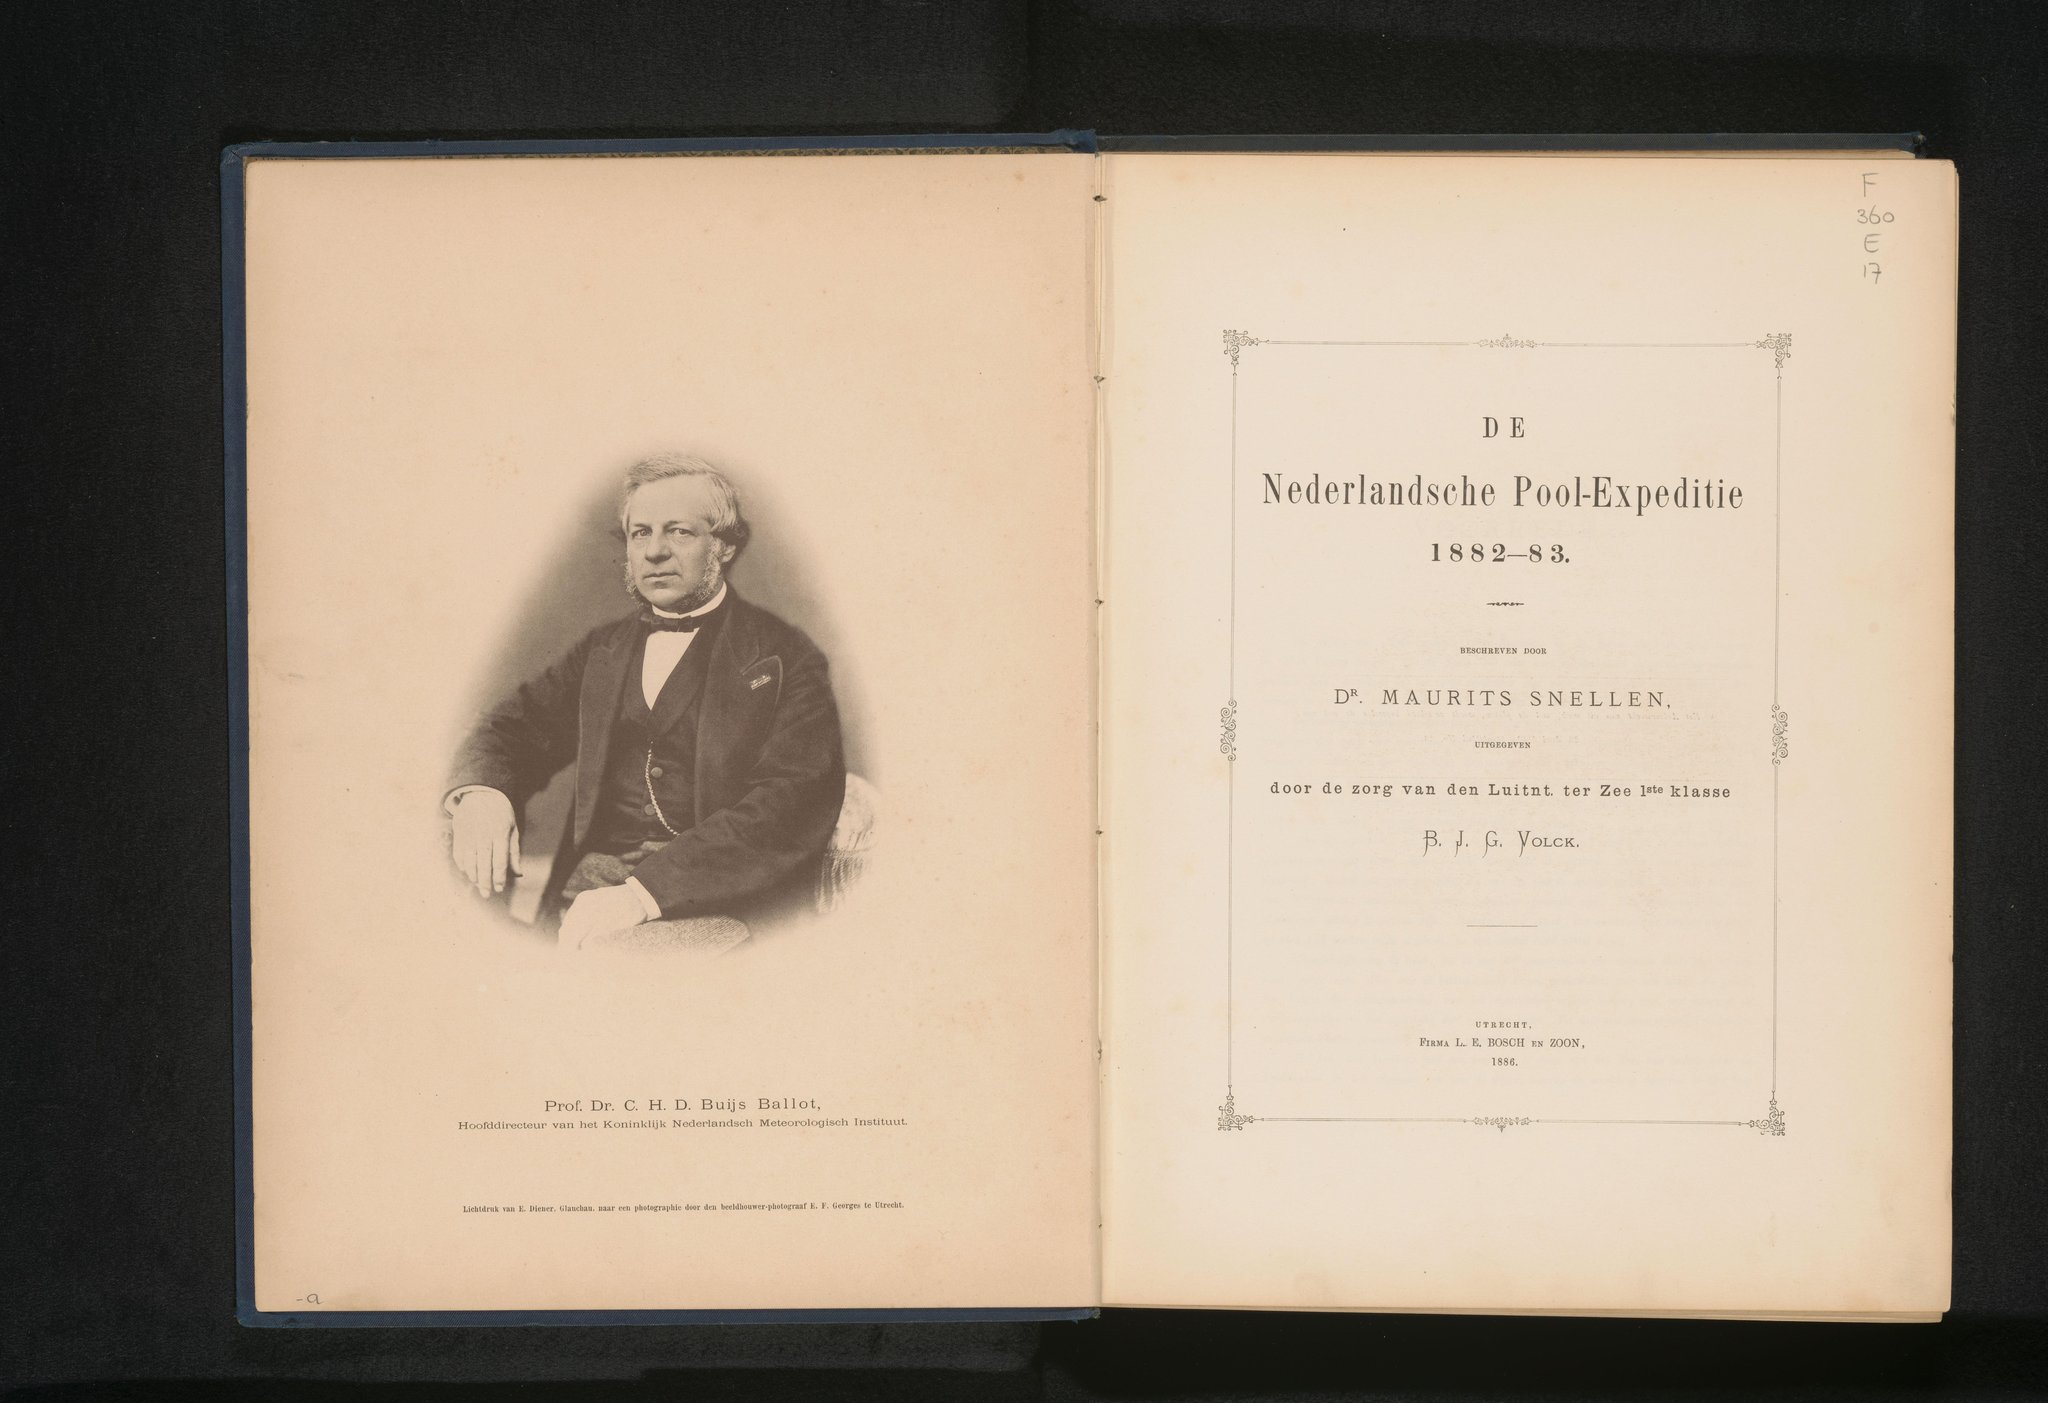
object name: book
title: De Nederlandsche Pool-expeditie, 1882-83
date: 1886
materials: linen, paper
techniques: photograph, decorated paper, printing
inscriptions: date: ‘Apr 2000’